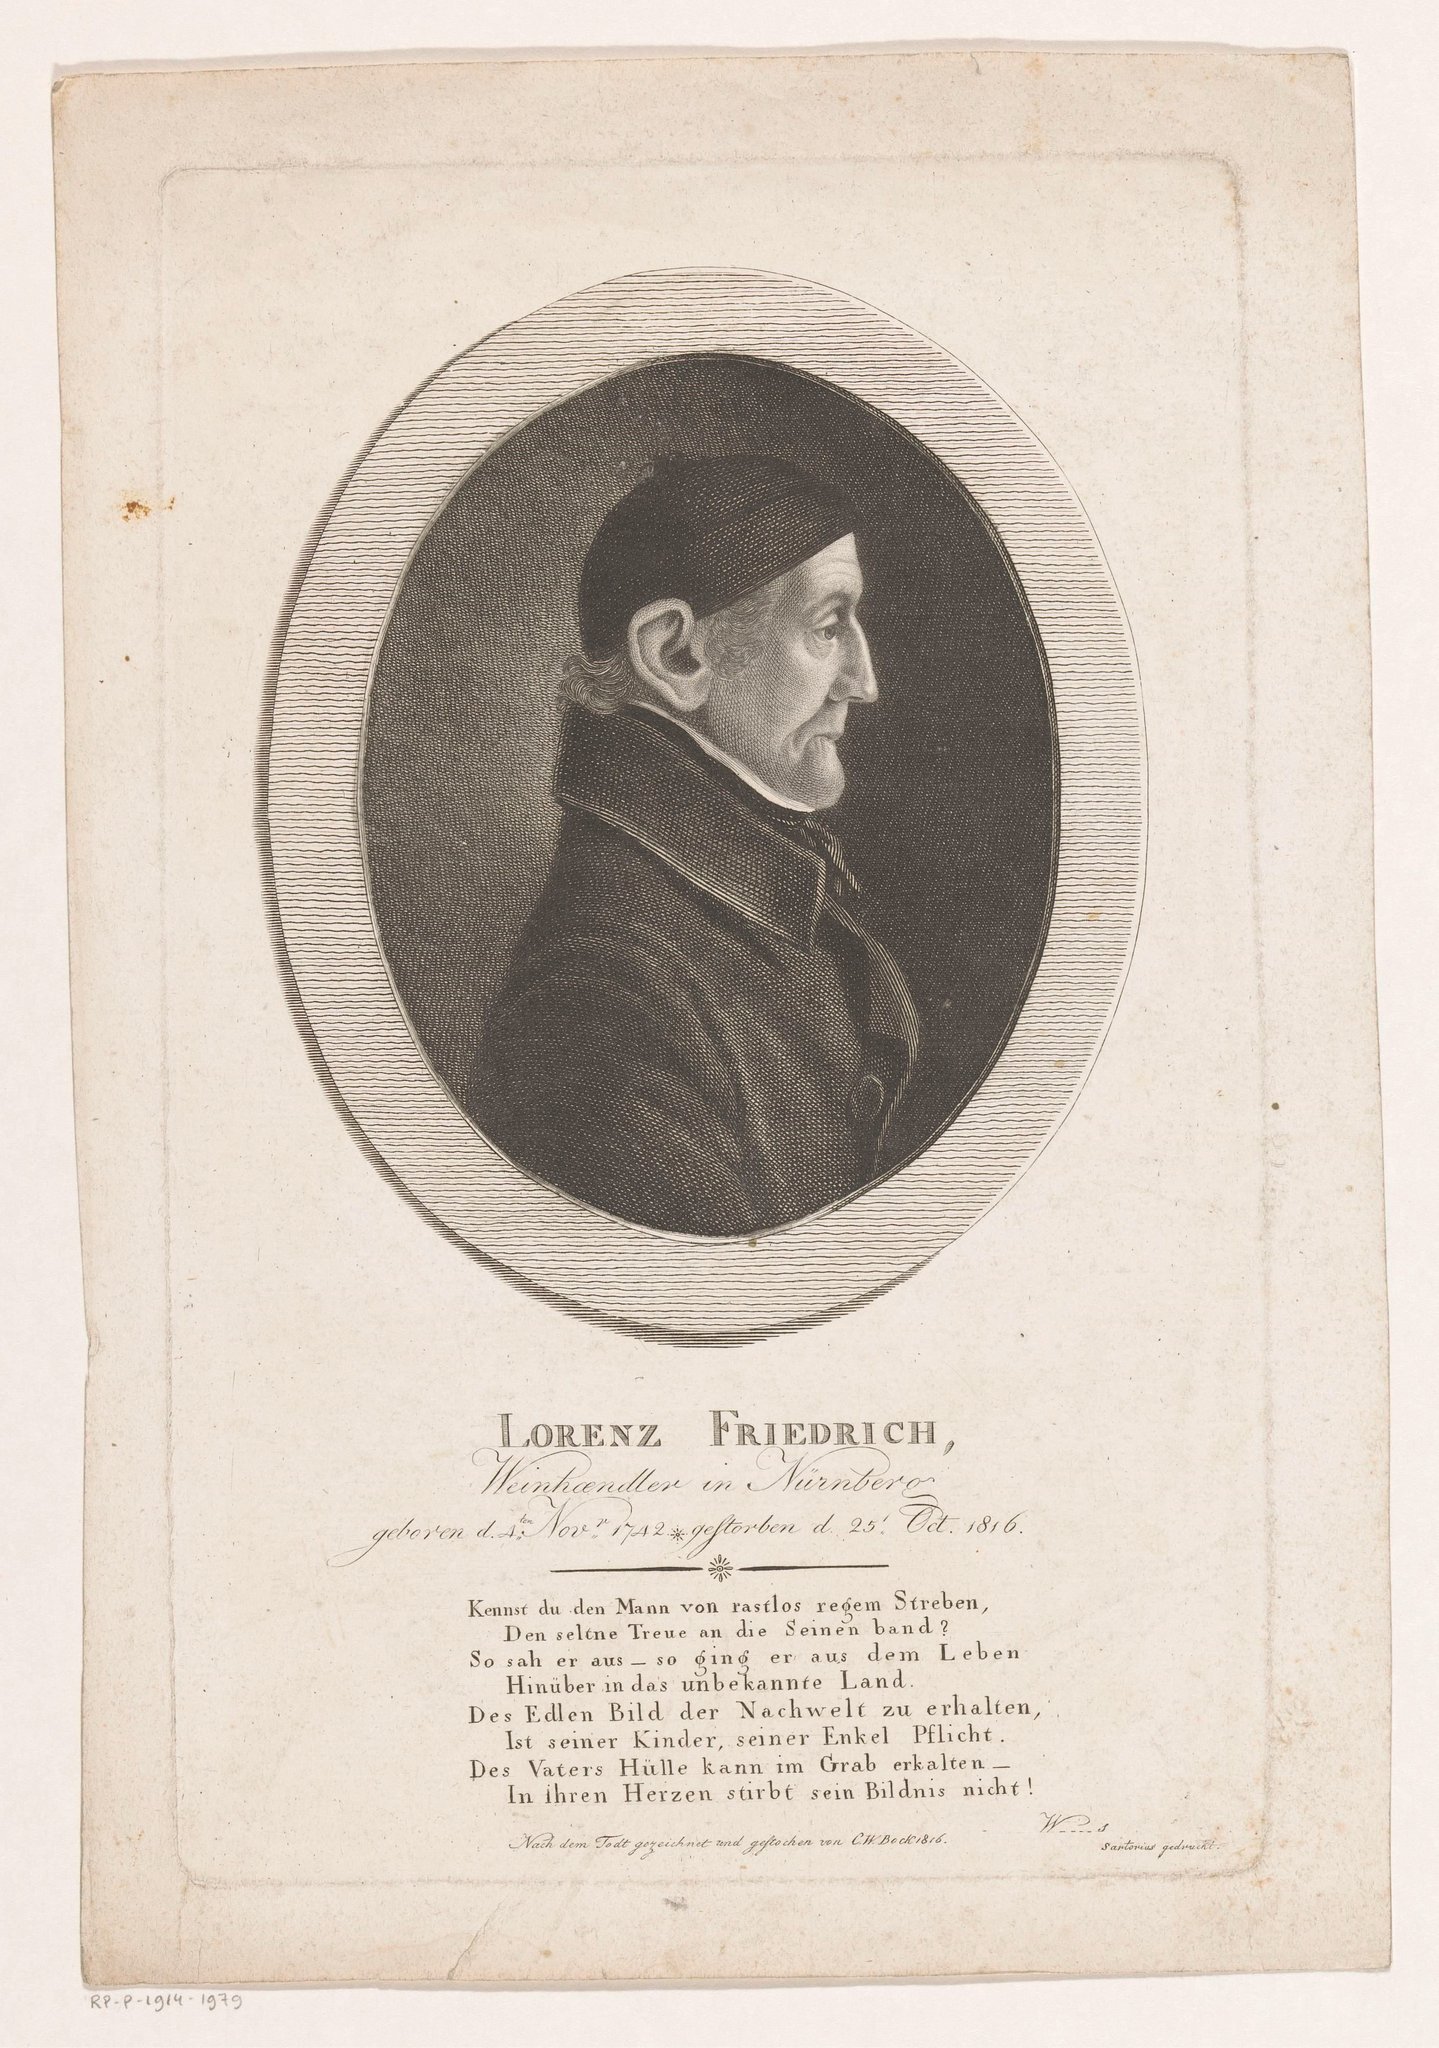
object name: print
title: Portret van Lorenz Friedrich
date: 1816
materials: paper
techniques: engraving, etching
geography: nuremberg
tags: historical persons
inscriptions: collector's mark: Lugt 2228